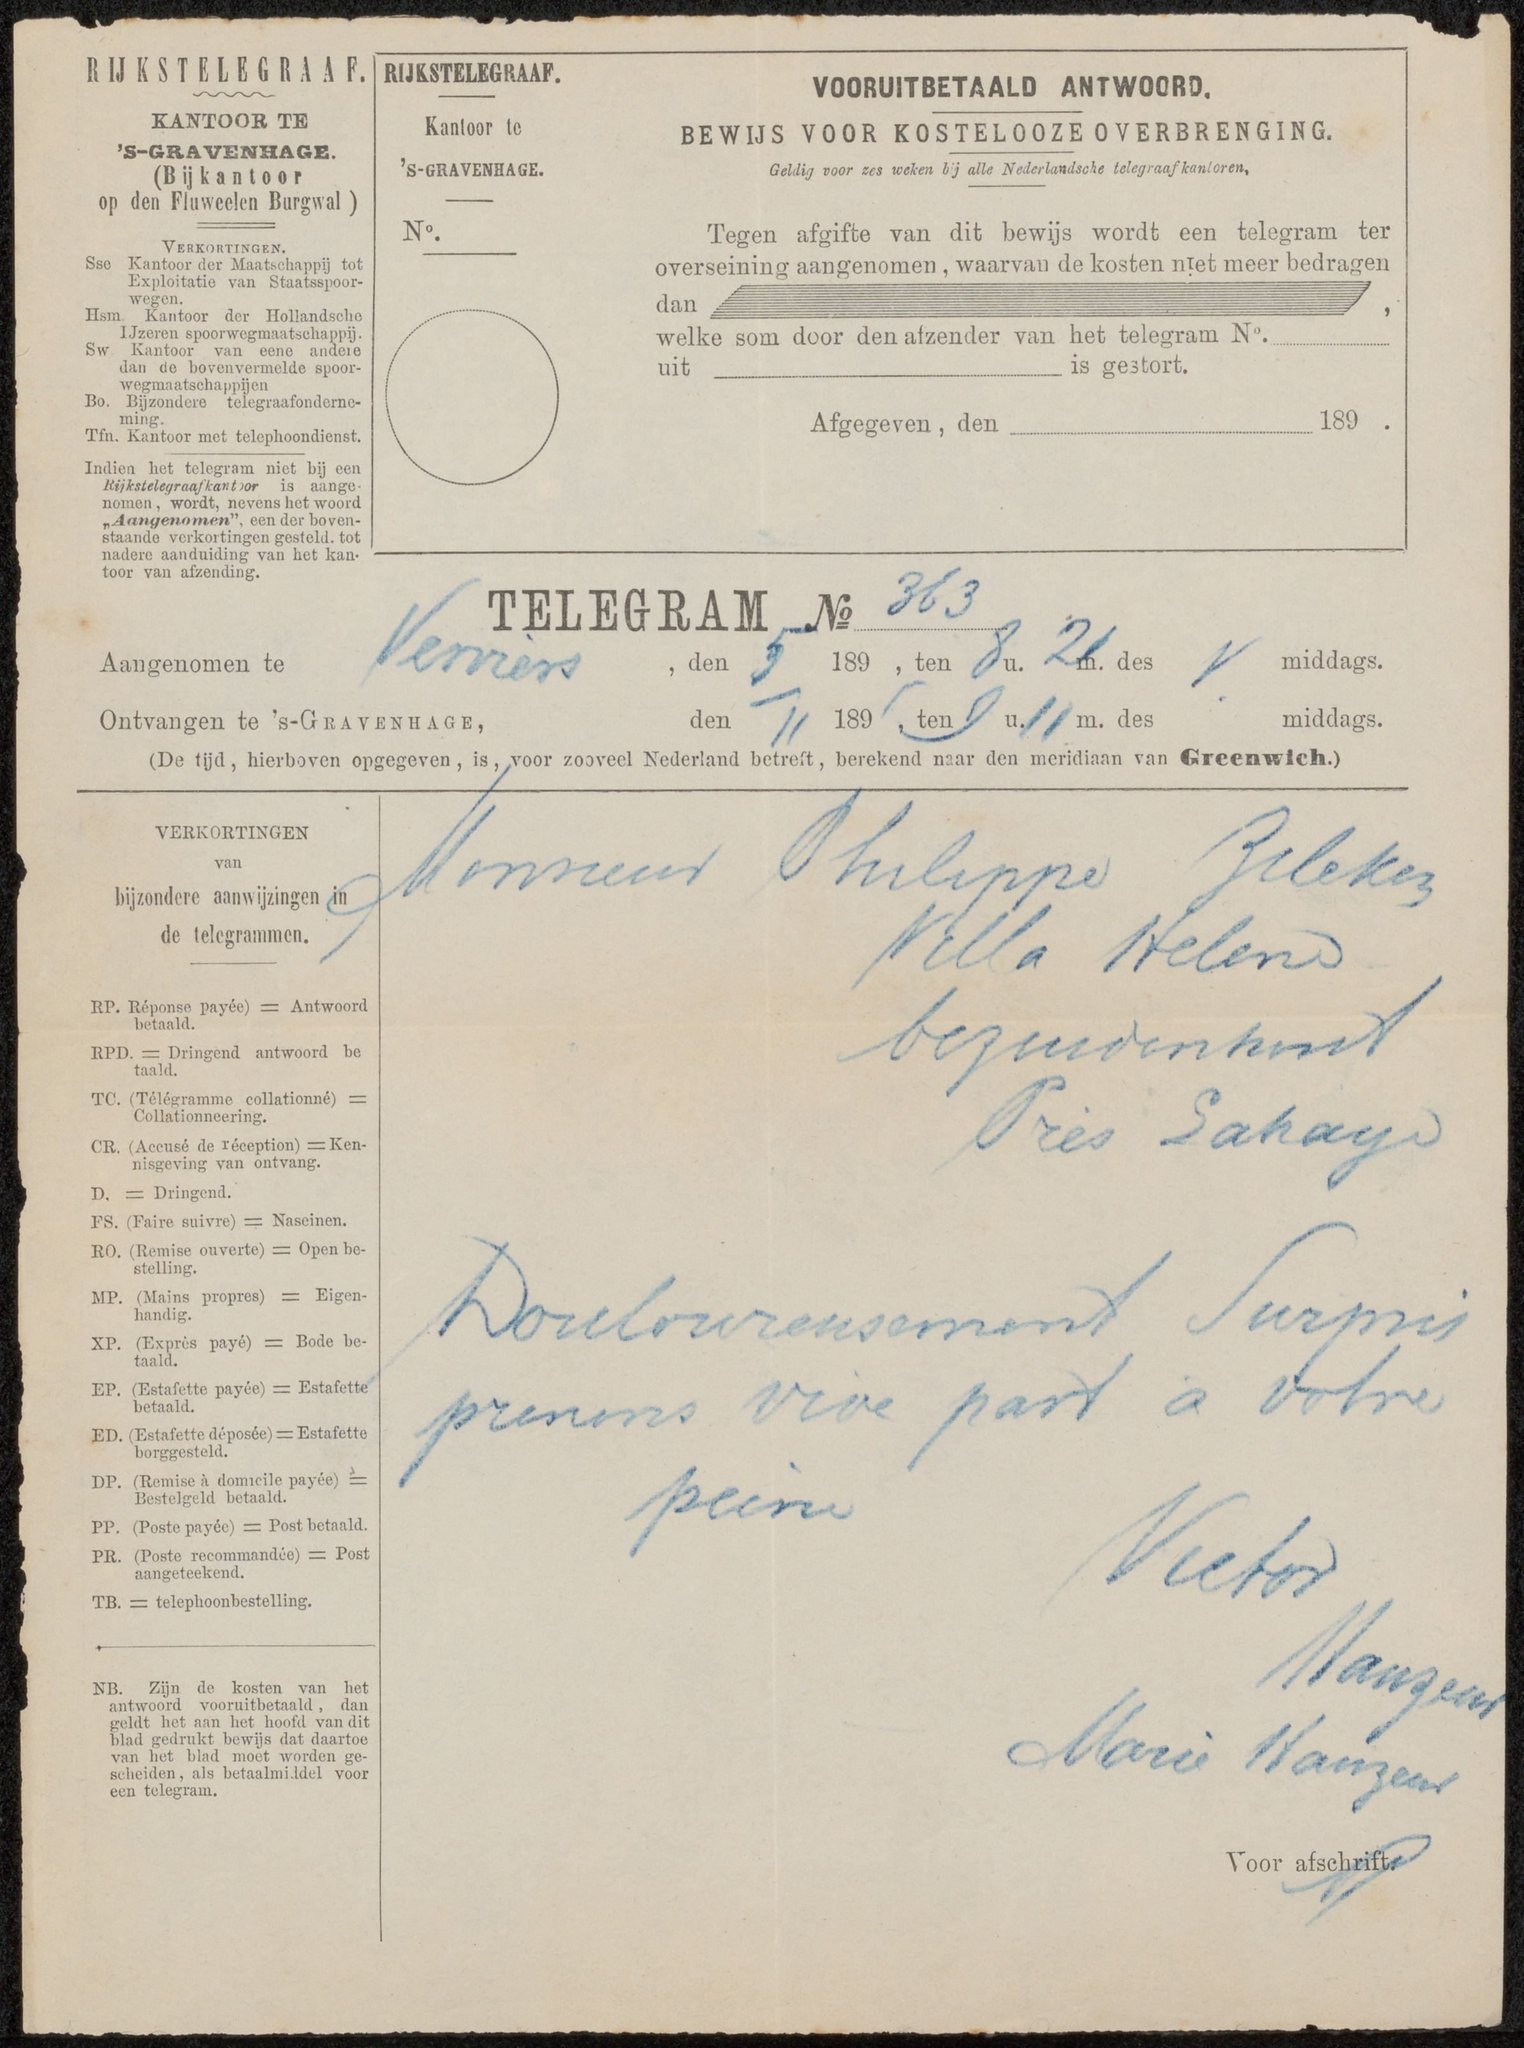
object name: telegram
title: Telegram aan Philip Zilcken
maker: marie hauzeur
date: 1895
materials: ink, paper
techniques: pen, printing, writing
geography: verviers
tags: brussels, helène lambertine hauzeur, painter, philip zilcken, passions, emotions, affections